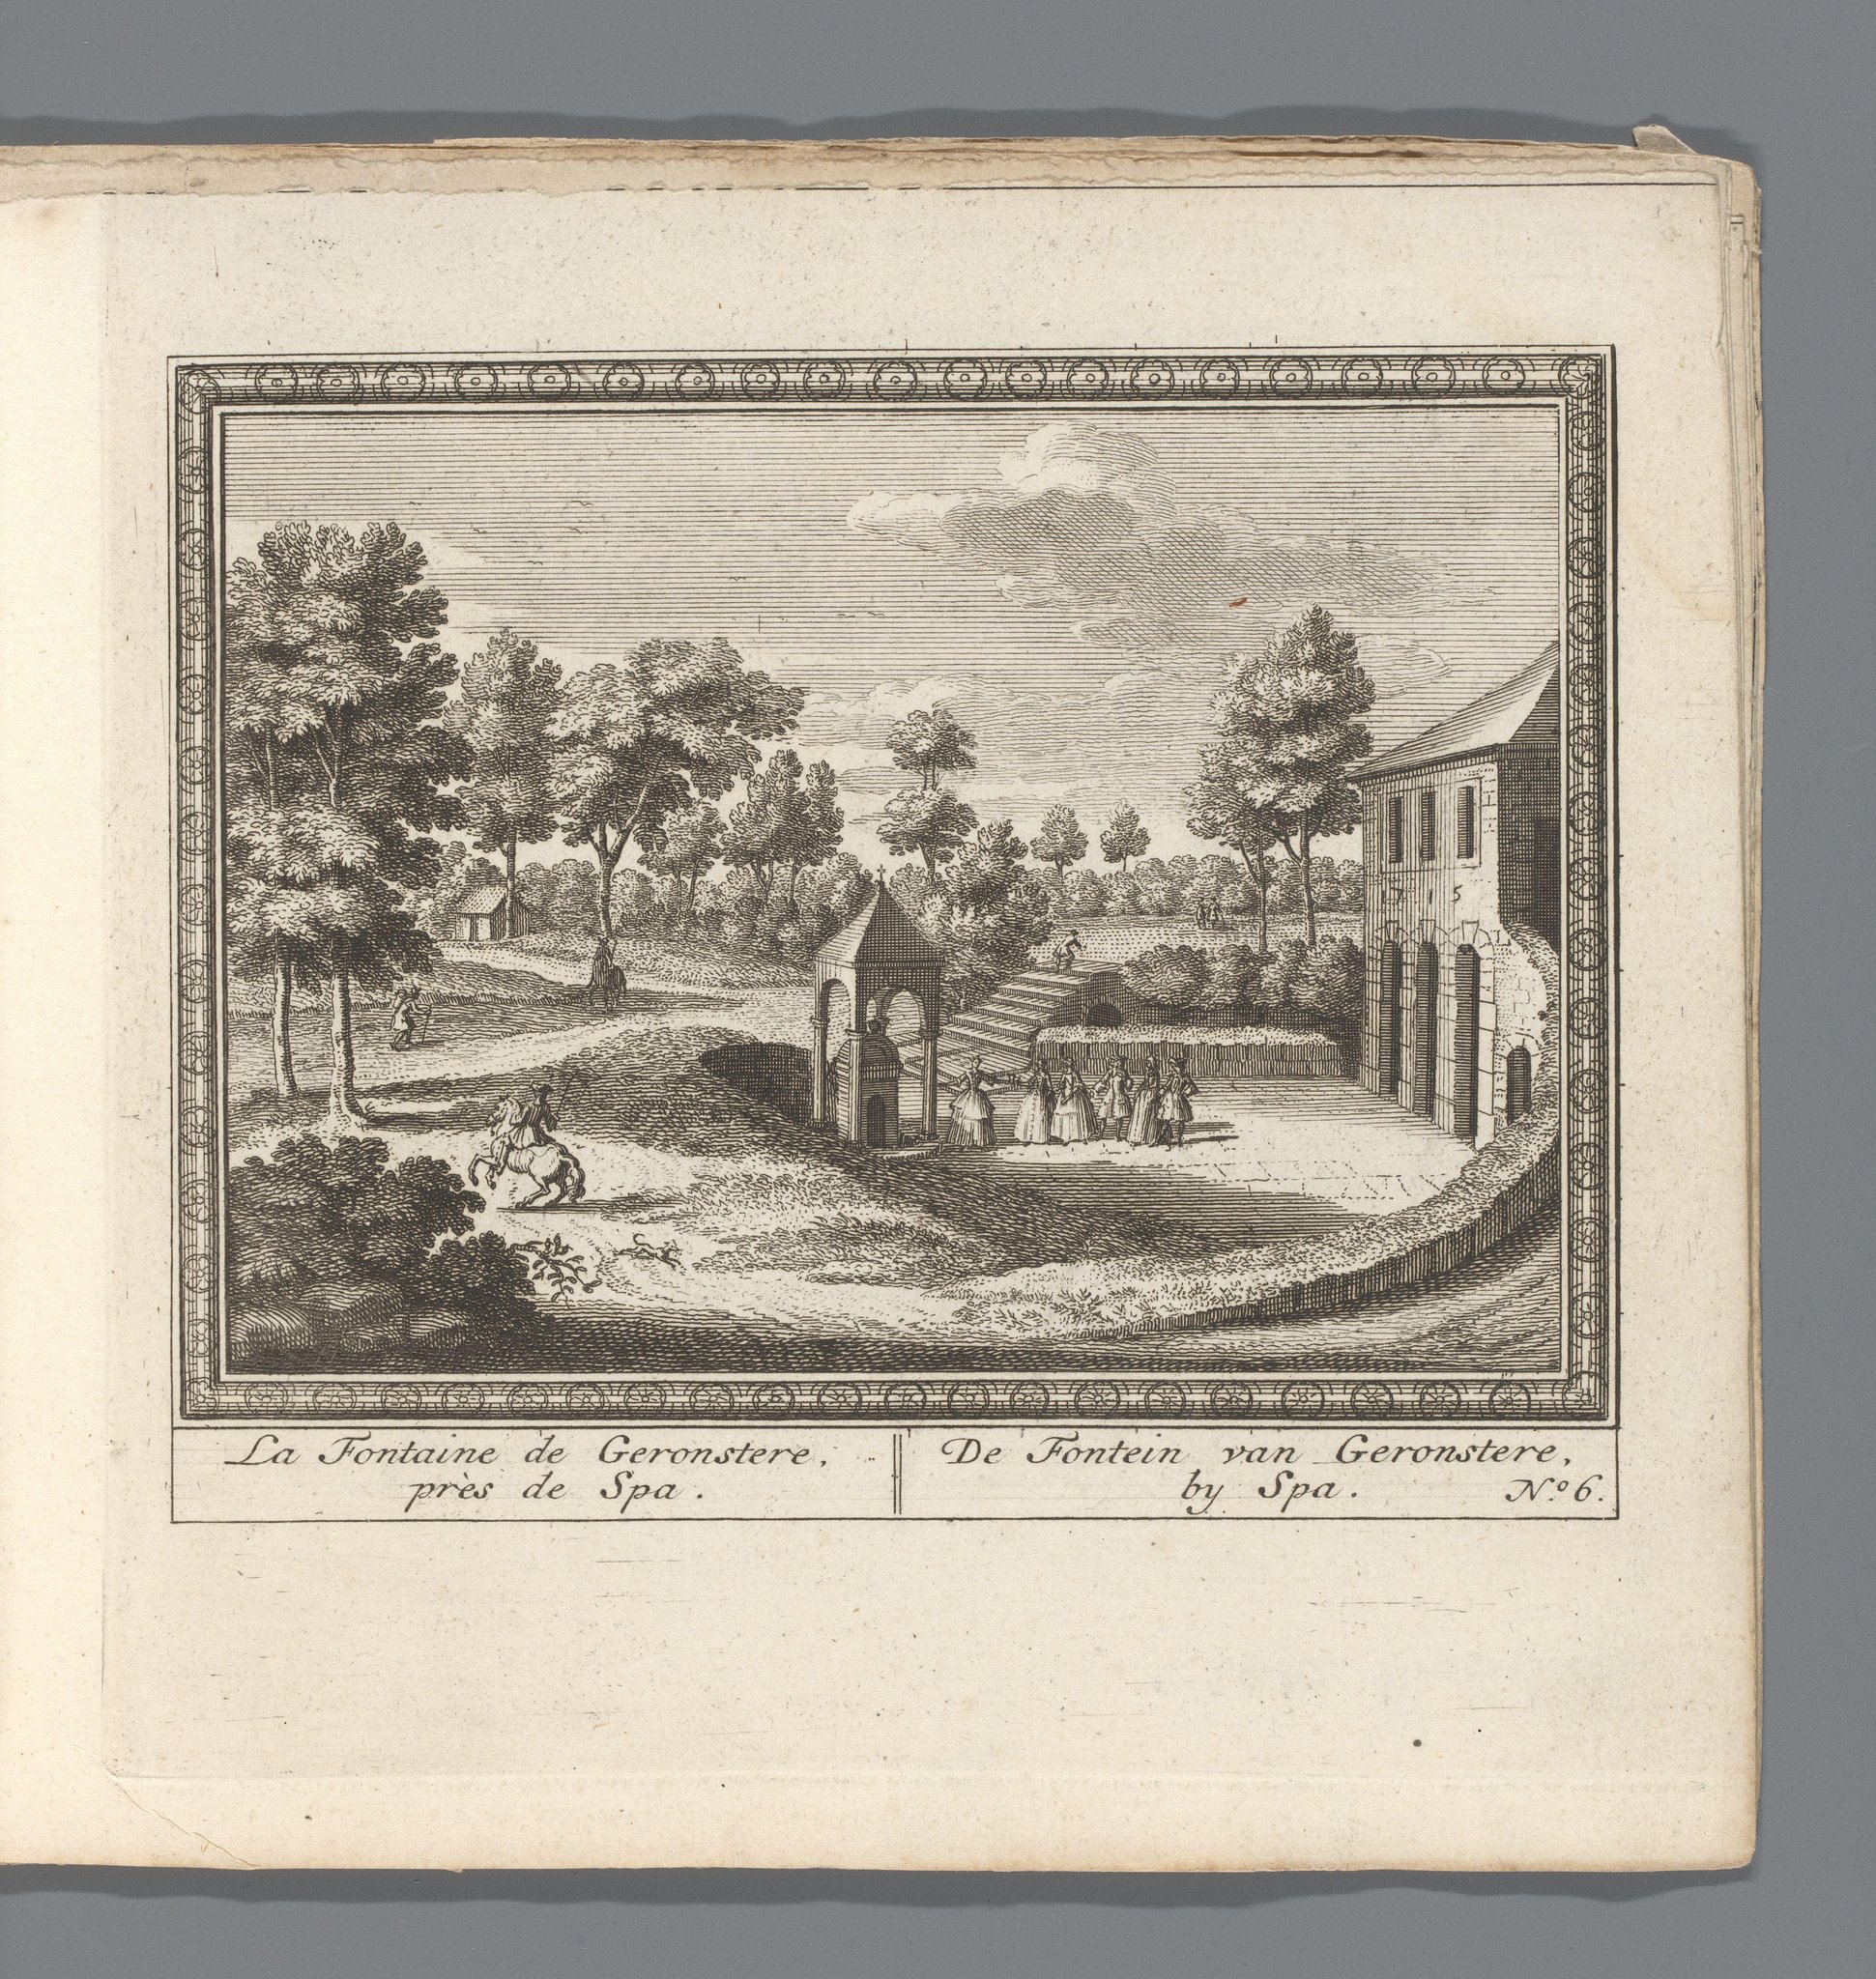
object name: print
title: Gezicht op de fontein van Geronstere bij Spa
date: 1734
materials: paper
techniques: etching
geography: amsterdam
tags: city-view in general; 'veduta', mineral water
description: Deze serie prenten is gebruikt in: Pöllnitz, Charles-Louis. Amuseums des eaux de Spa. Ouvrage utile a ceux qui vont boire ces eaux minérales sur les lieux. 2 dln. Amsterdam: Pieter Mortier, 1734. In deze uitgave zijn de prenten echter gevouwen. Mogelijk is deze serie een losse uitgave van de prenten. Er ontbreekt één prent die in het boek is opgenomen (nr. 4), waarop geen landschap is afgebeeld.